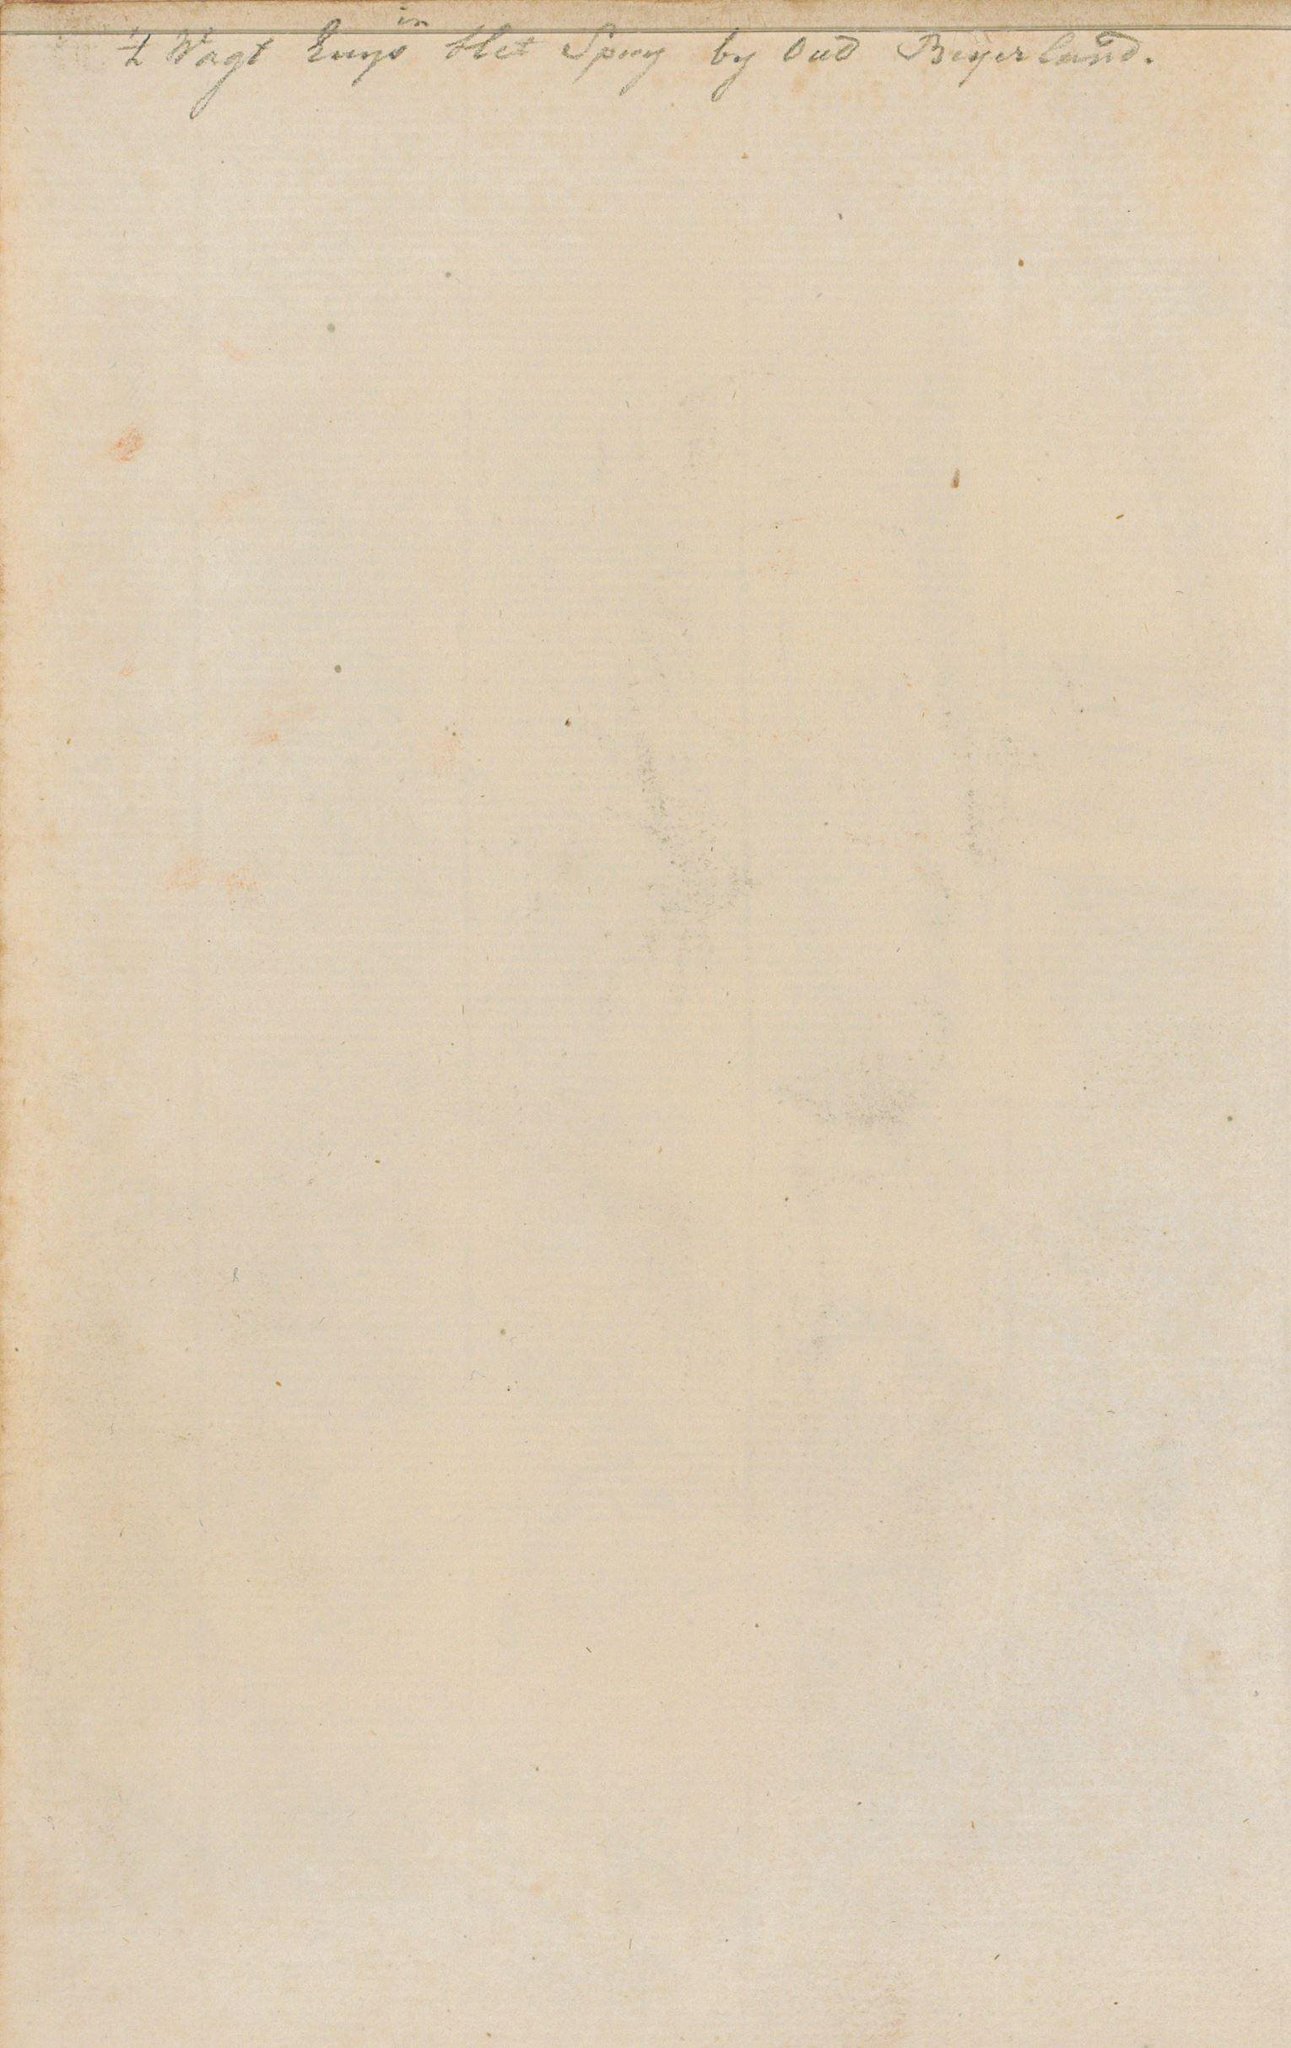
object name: sketchbook leaf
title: Notitie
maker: jacob perkois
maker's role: draughtsman, print maker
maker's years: 1756-1804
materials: paper, pencil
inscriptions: annotation: ‘´t Wagt [...]ys in Het Sp[...]g bij oud Beyerland.’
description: Bladzijde 32 uit een schetsboek met 78 bladzijden.